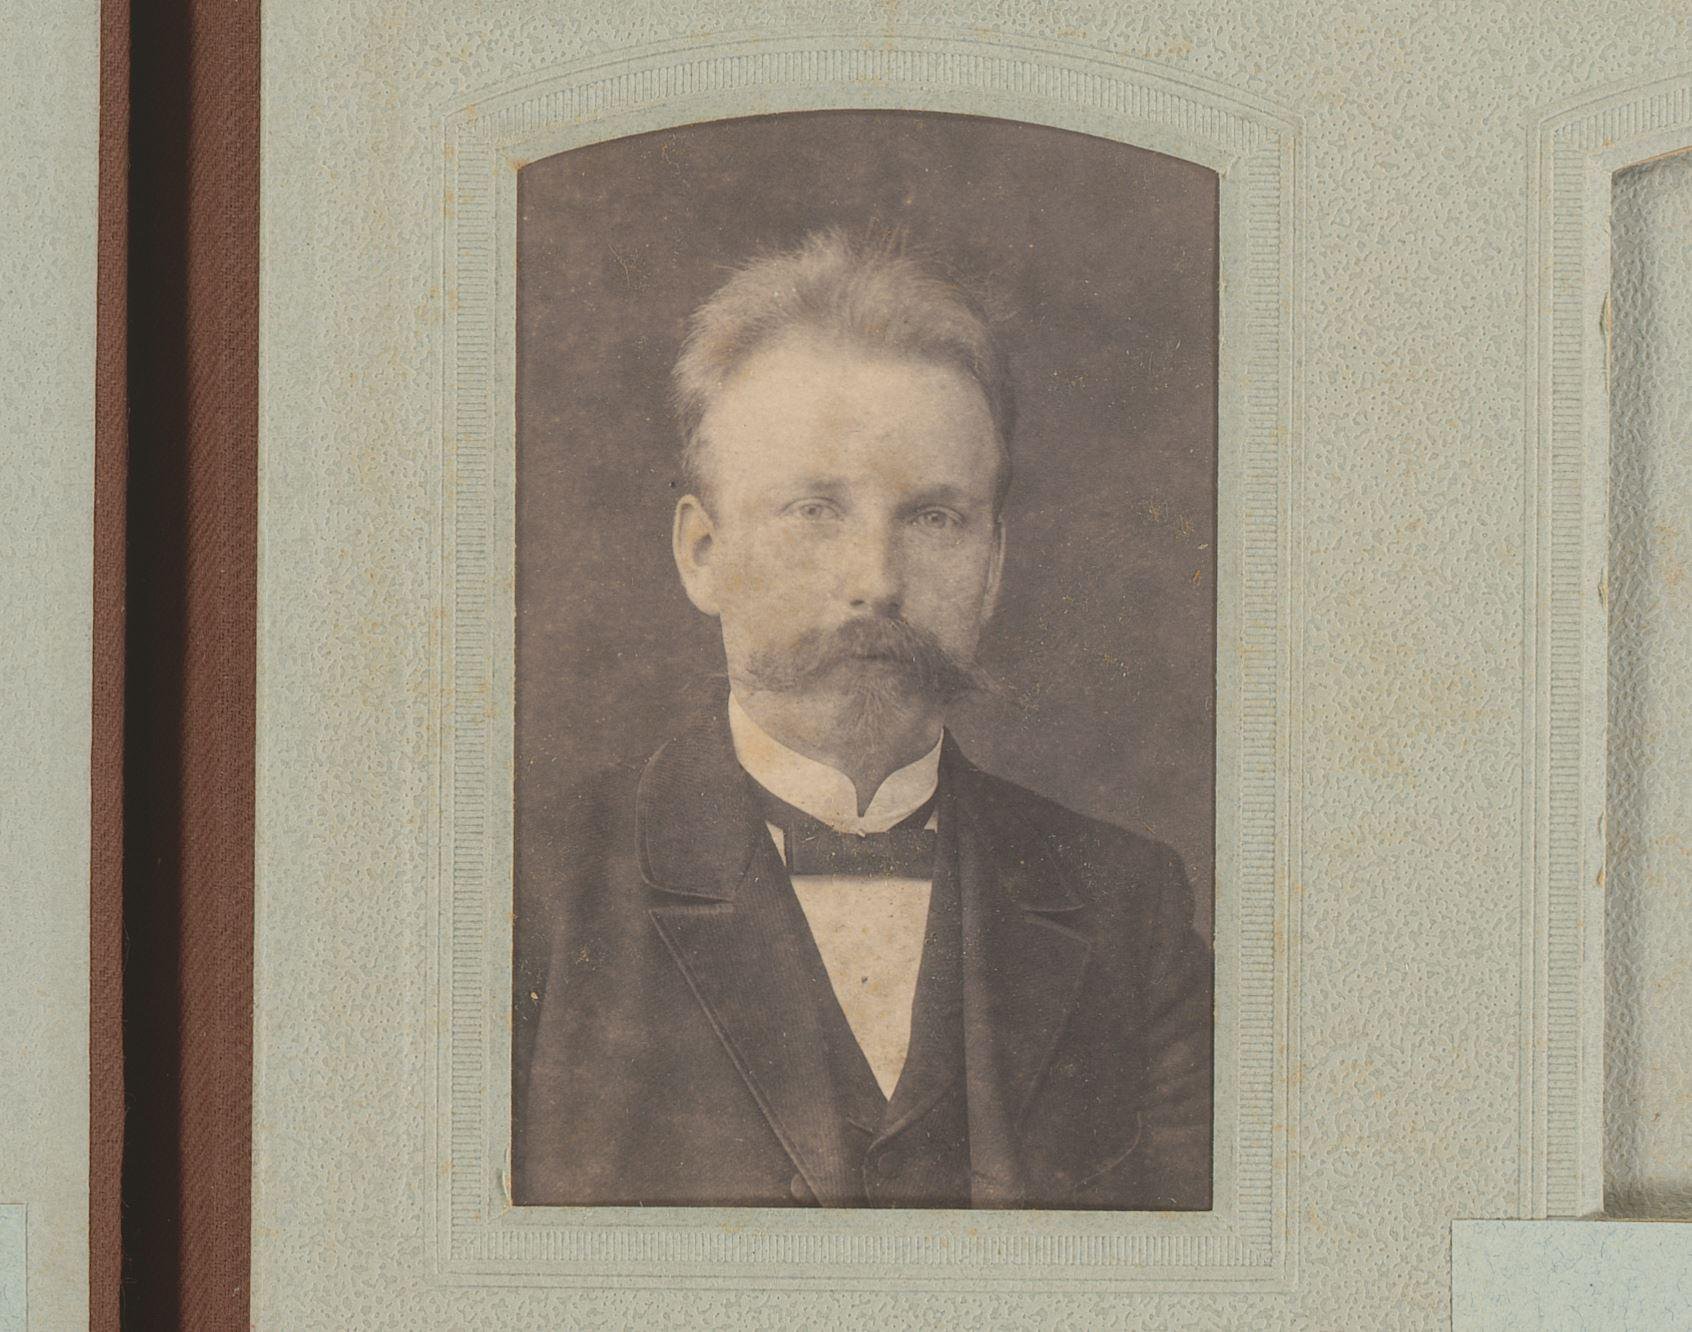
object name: album leaf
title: Portret van een onbekende man met snor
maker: g. müller (fotograaf)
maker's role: fotograaf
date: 1870-1900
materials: cardboard, paper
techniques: albumen print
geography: brandenburg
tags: adult man, anonymous historical person portrayed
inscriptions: inscription: ‘G. Müller/ Maler & Photograph./ Atelier für/ Portrait, Kunst u. Gewerbe/ Brandenburg a/H./ Grosse Münzenstrasse No. 3.’